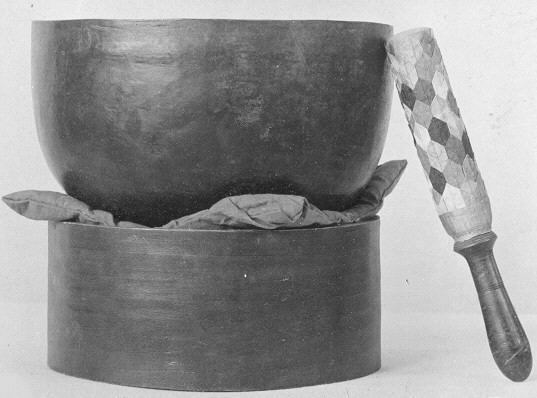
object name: dobachi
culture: japanese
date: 1801-1900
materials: brass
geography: japan